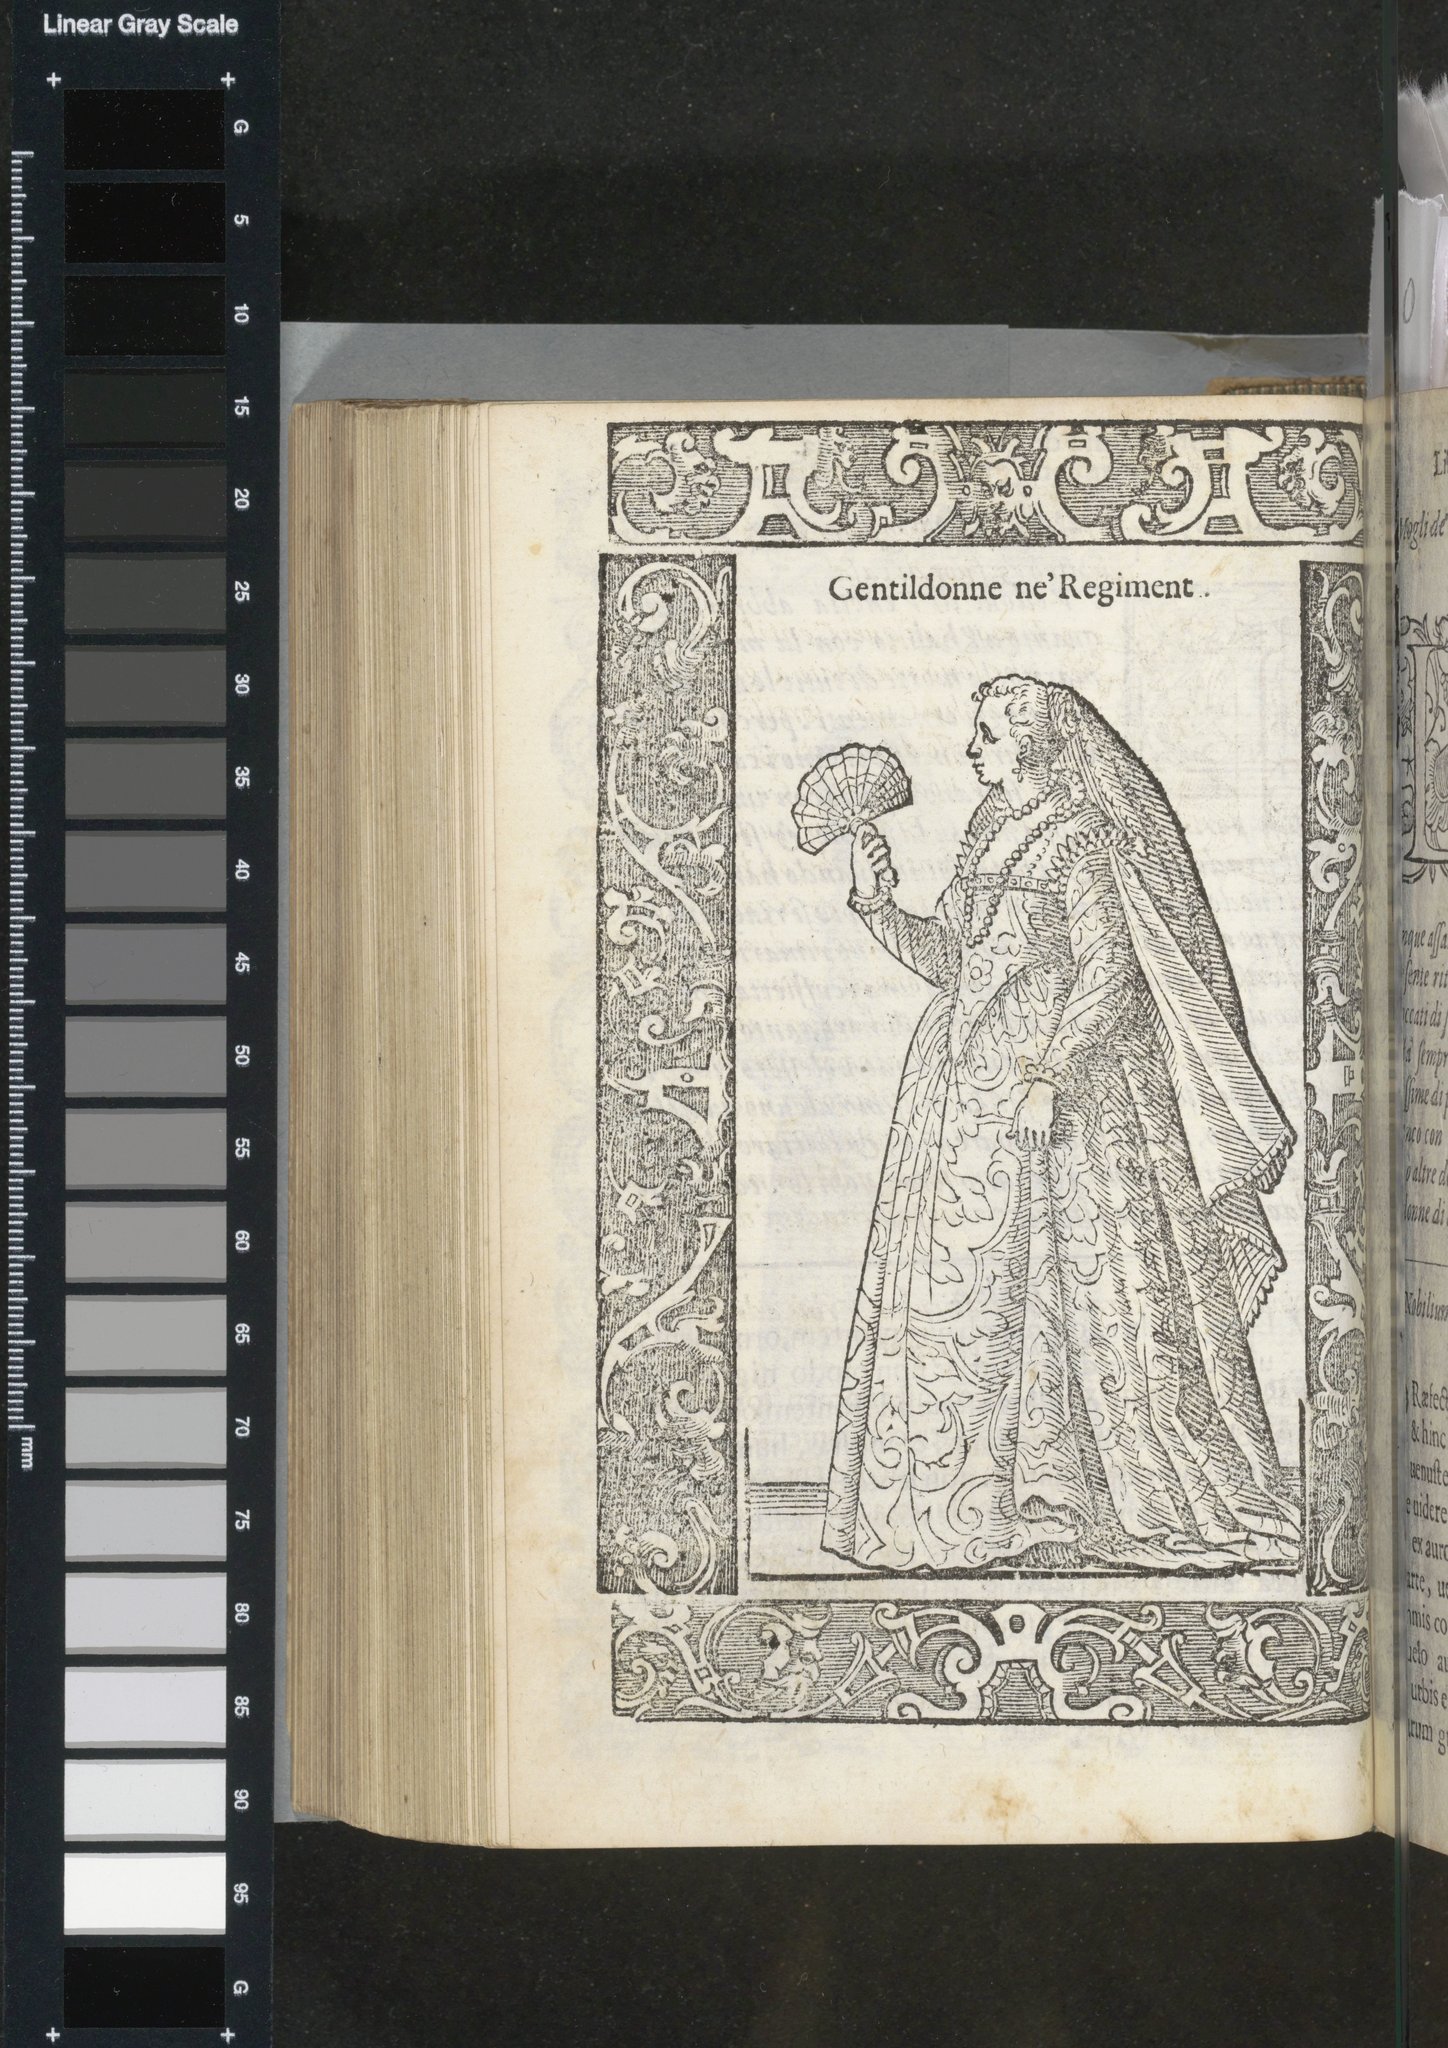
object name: costume print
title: Gentildonne ne’reggimenti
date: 1598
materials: paper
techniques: woodcut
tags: ear-rings (+ women's clothes), fashion plates, dress, gown (+ women's clothes), pearl; pearl necklace (+ women's clothes)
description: Hooggeplaatste dame uit Venetië, rijk gekleed volgens het decorum. Zij draagt een overkleed van brokaat en een lange sluier. Parelsnoeren om de hals en oorbellen met parels in het oor. Vouwwaaier in de hand. In ornamentrand.